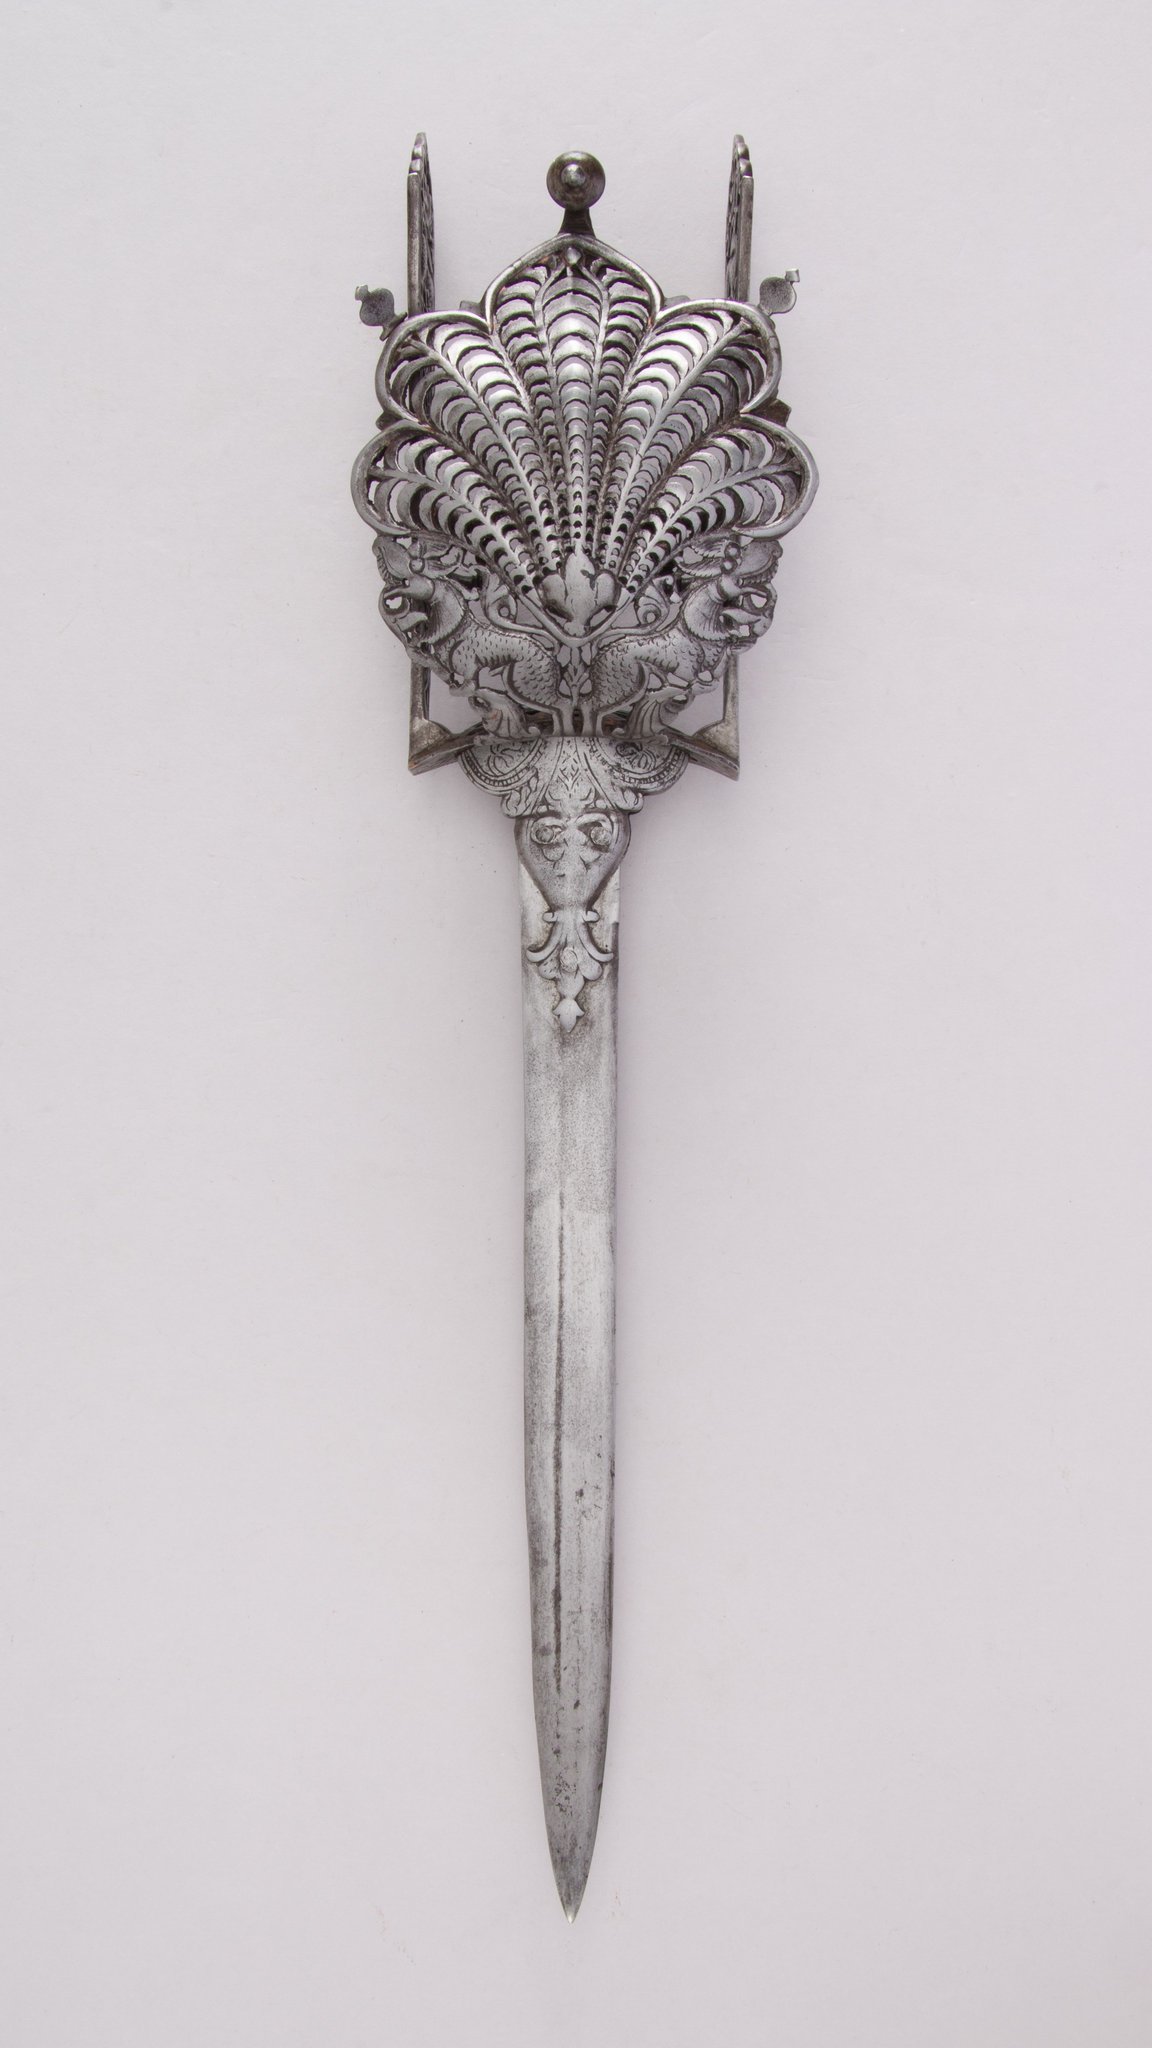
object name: dagger katar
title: Dagger (Katar)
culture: indian or european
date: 1601-1700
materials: steel